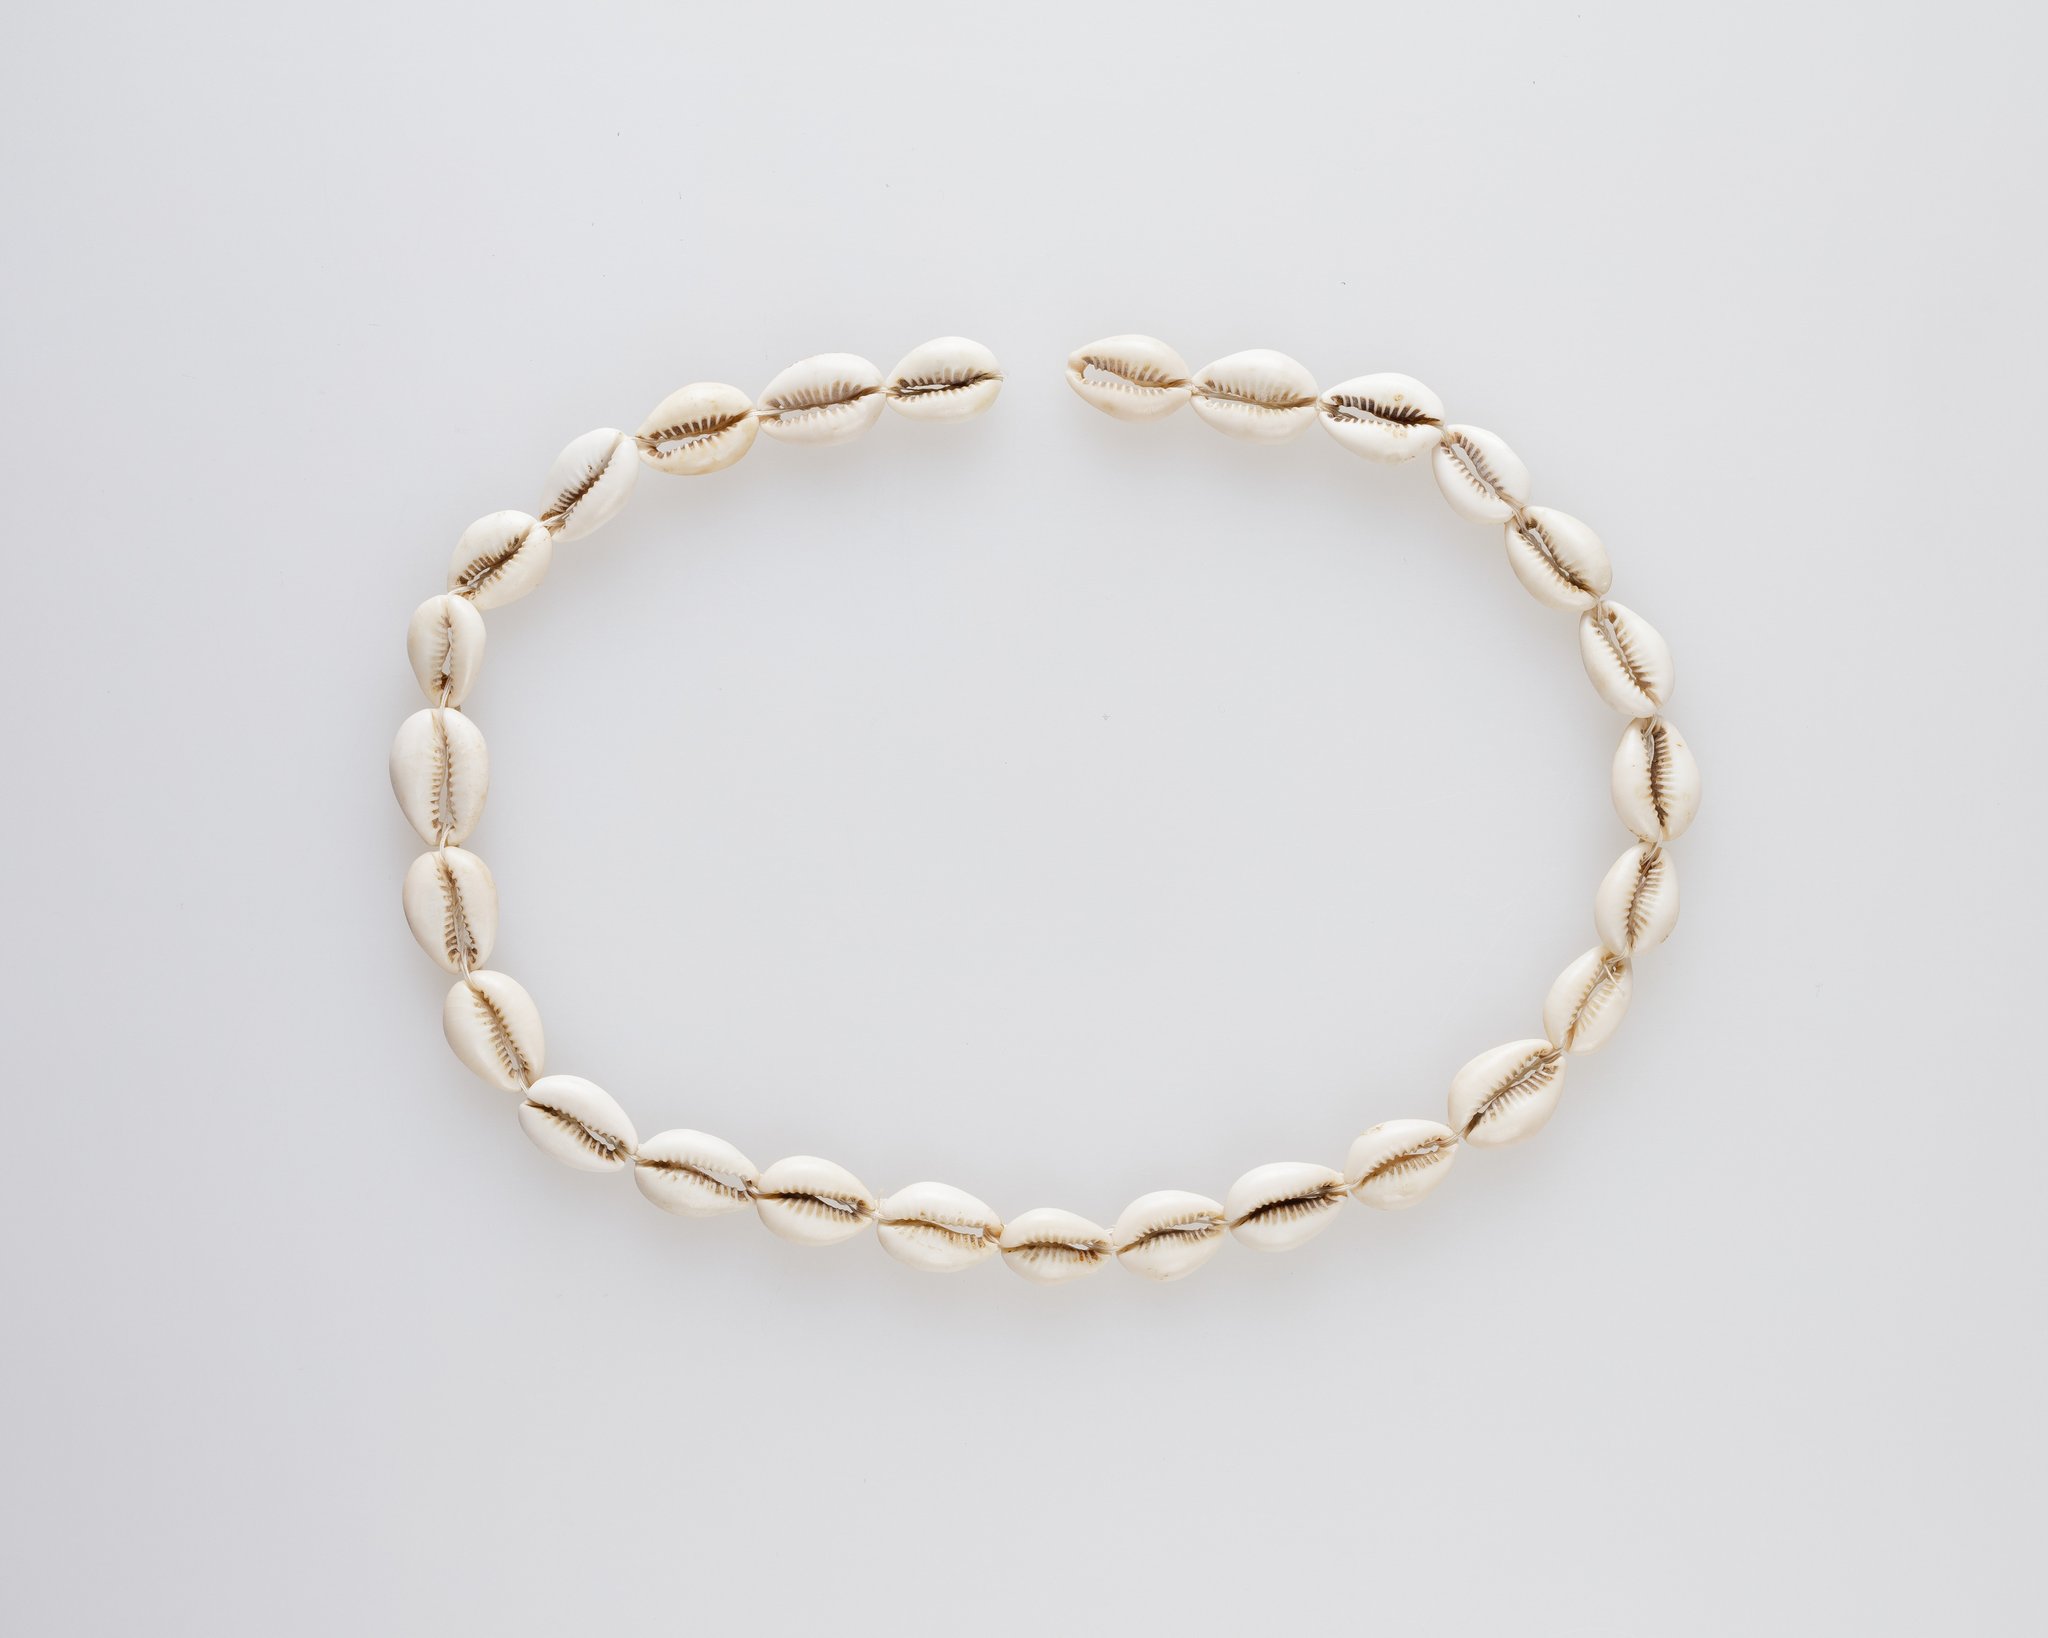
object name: shell, string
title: String of cowrie shells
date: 1070-343 BCE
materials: shell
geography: egypt